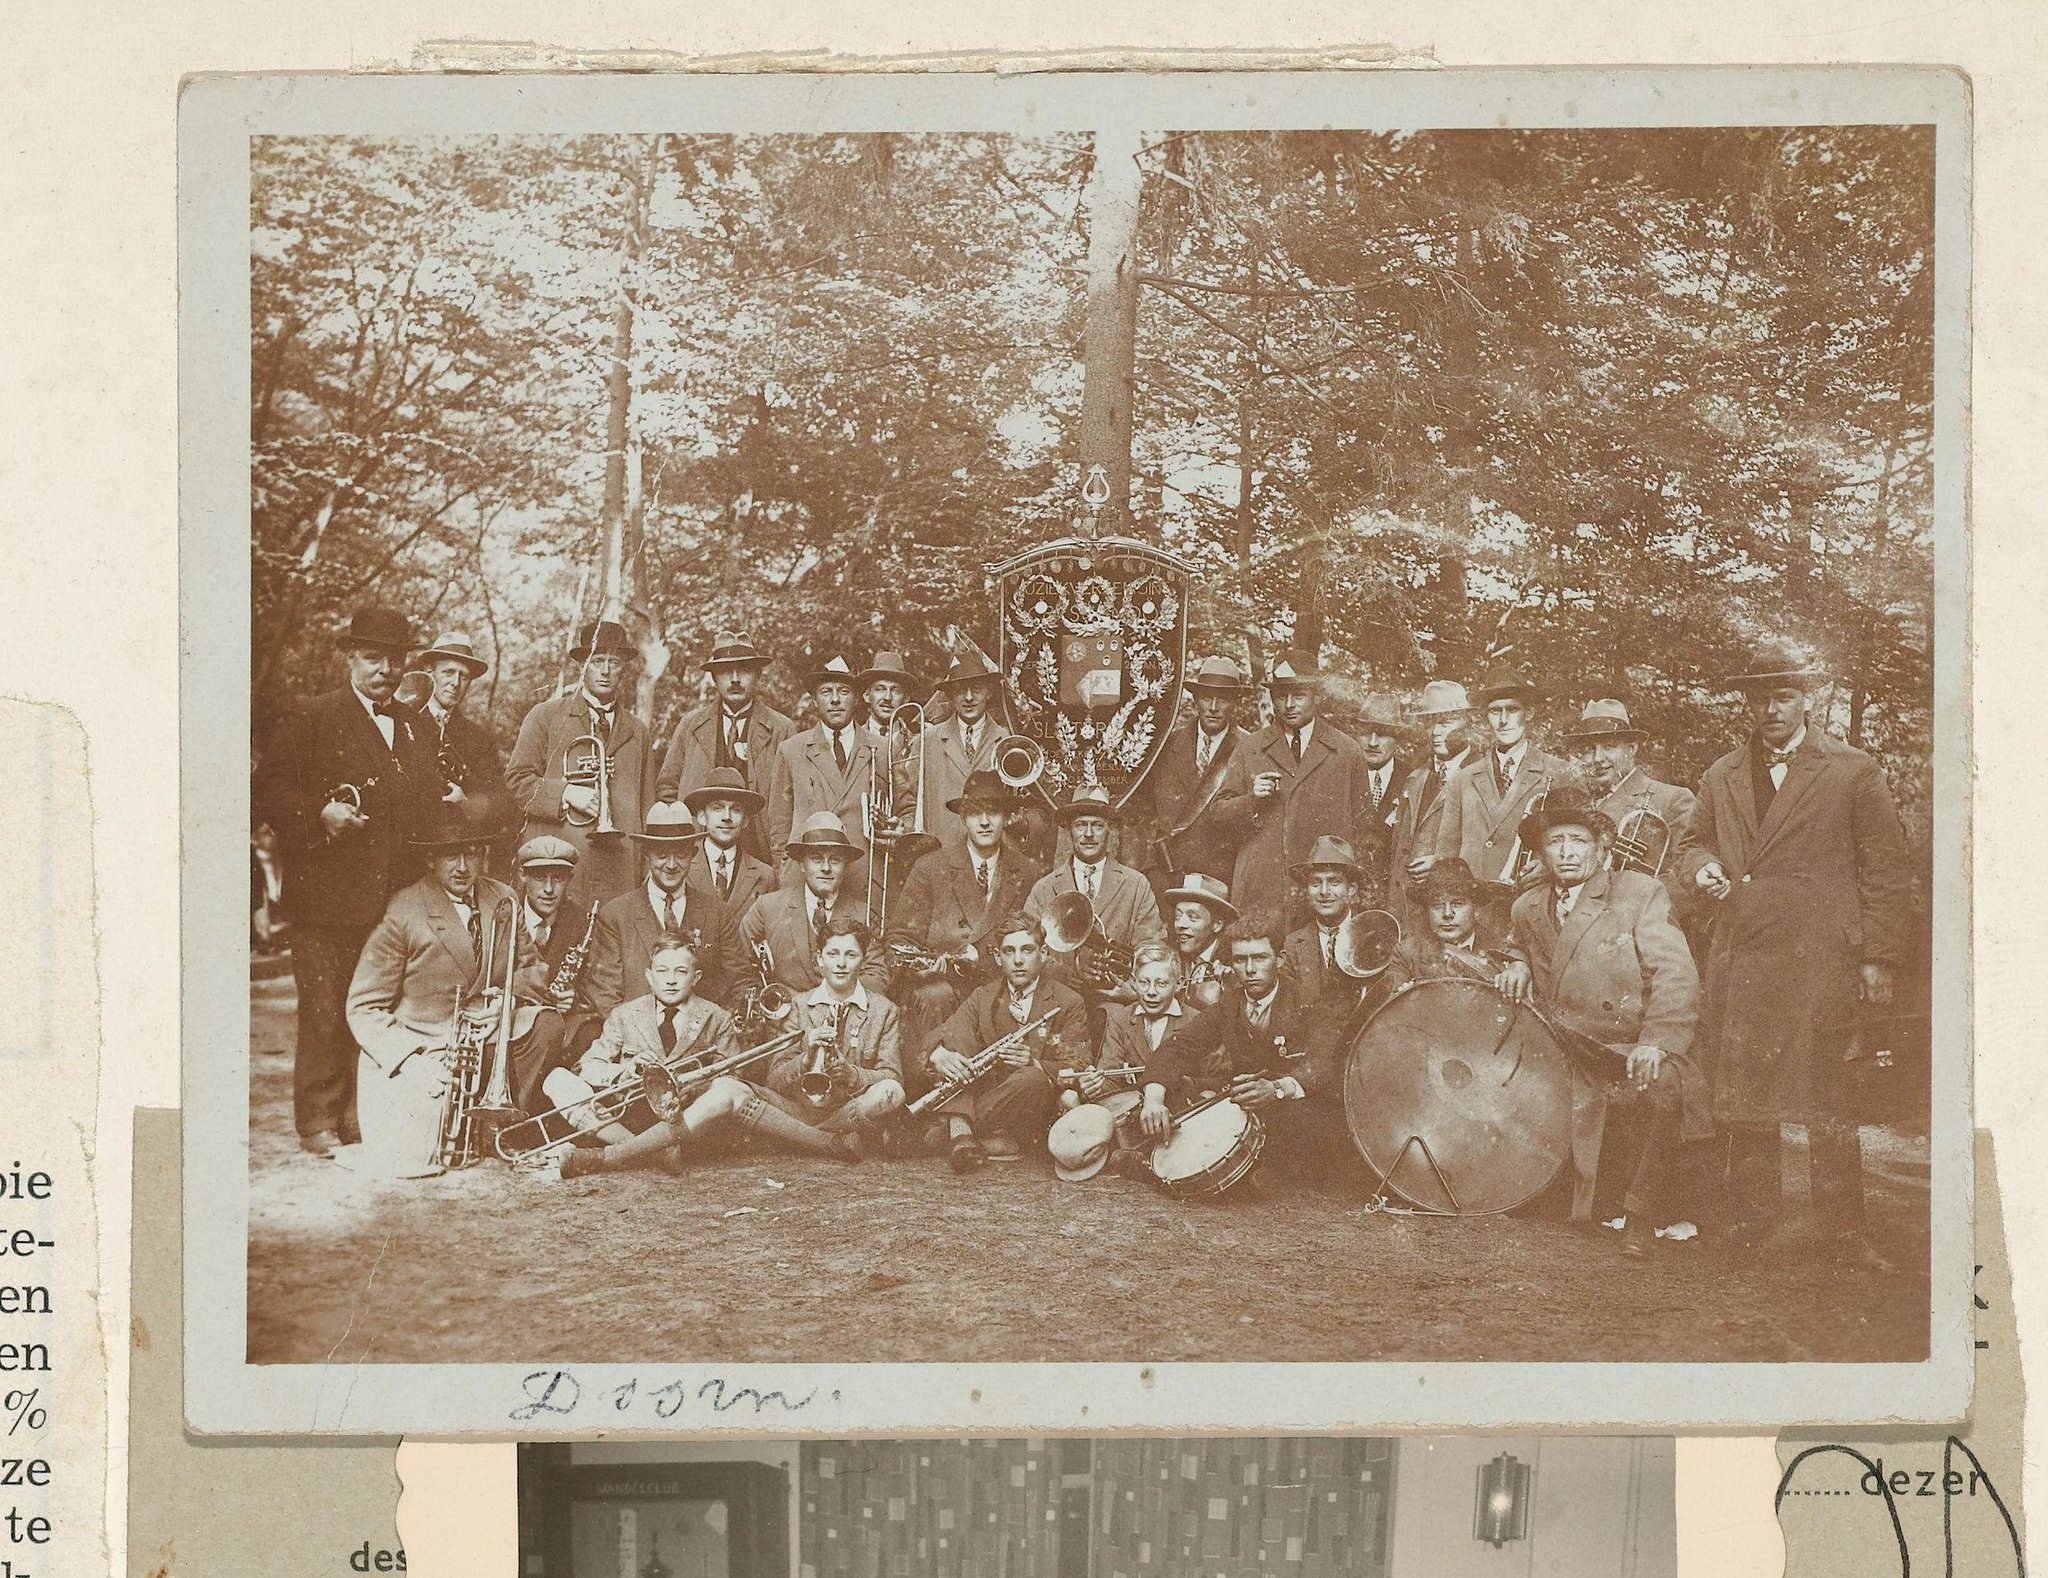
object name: photograph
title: Receptie ter gelegenheid van het 60-jarig bestaan van muziekgezelschap Crescendo waarbij het bestuur wordt gefeliciteerd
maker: Anonymous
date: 1950-1960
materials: photographic support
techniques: gelatin silver print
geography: netherlands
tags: anonymous historical persons portrayed in a group, in a group-portrait, amsterdam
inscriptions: name: ‘Volden voorzitter’